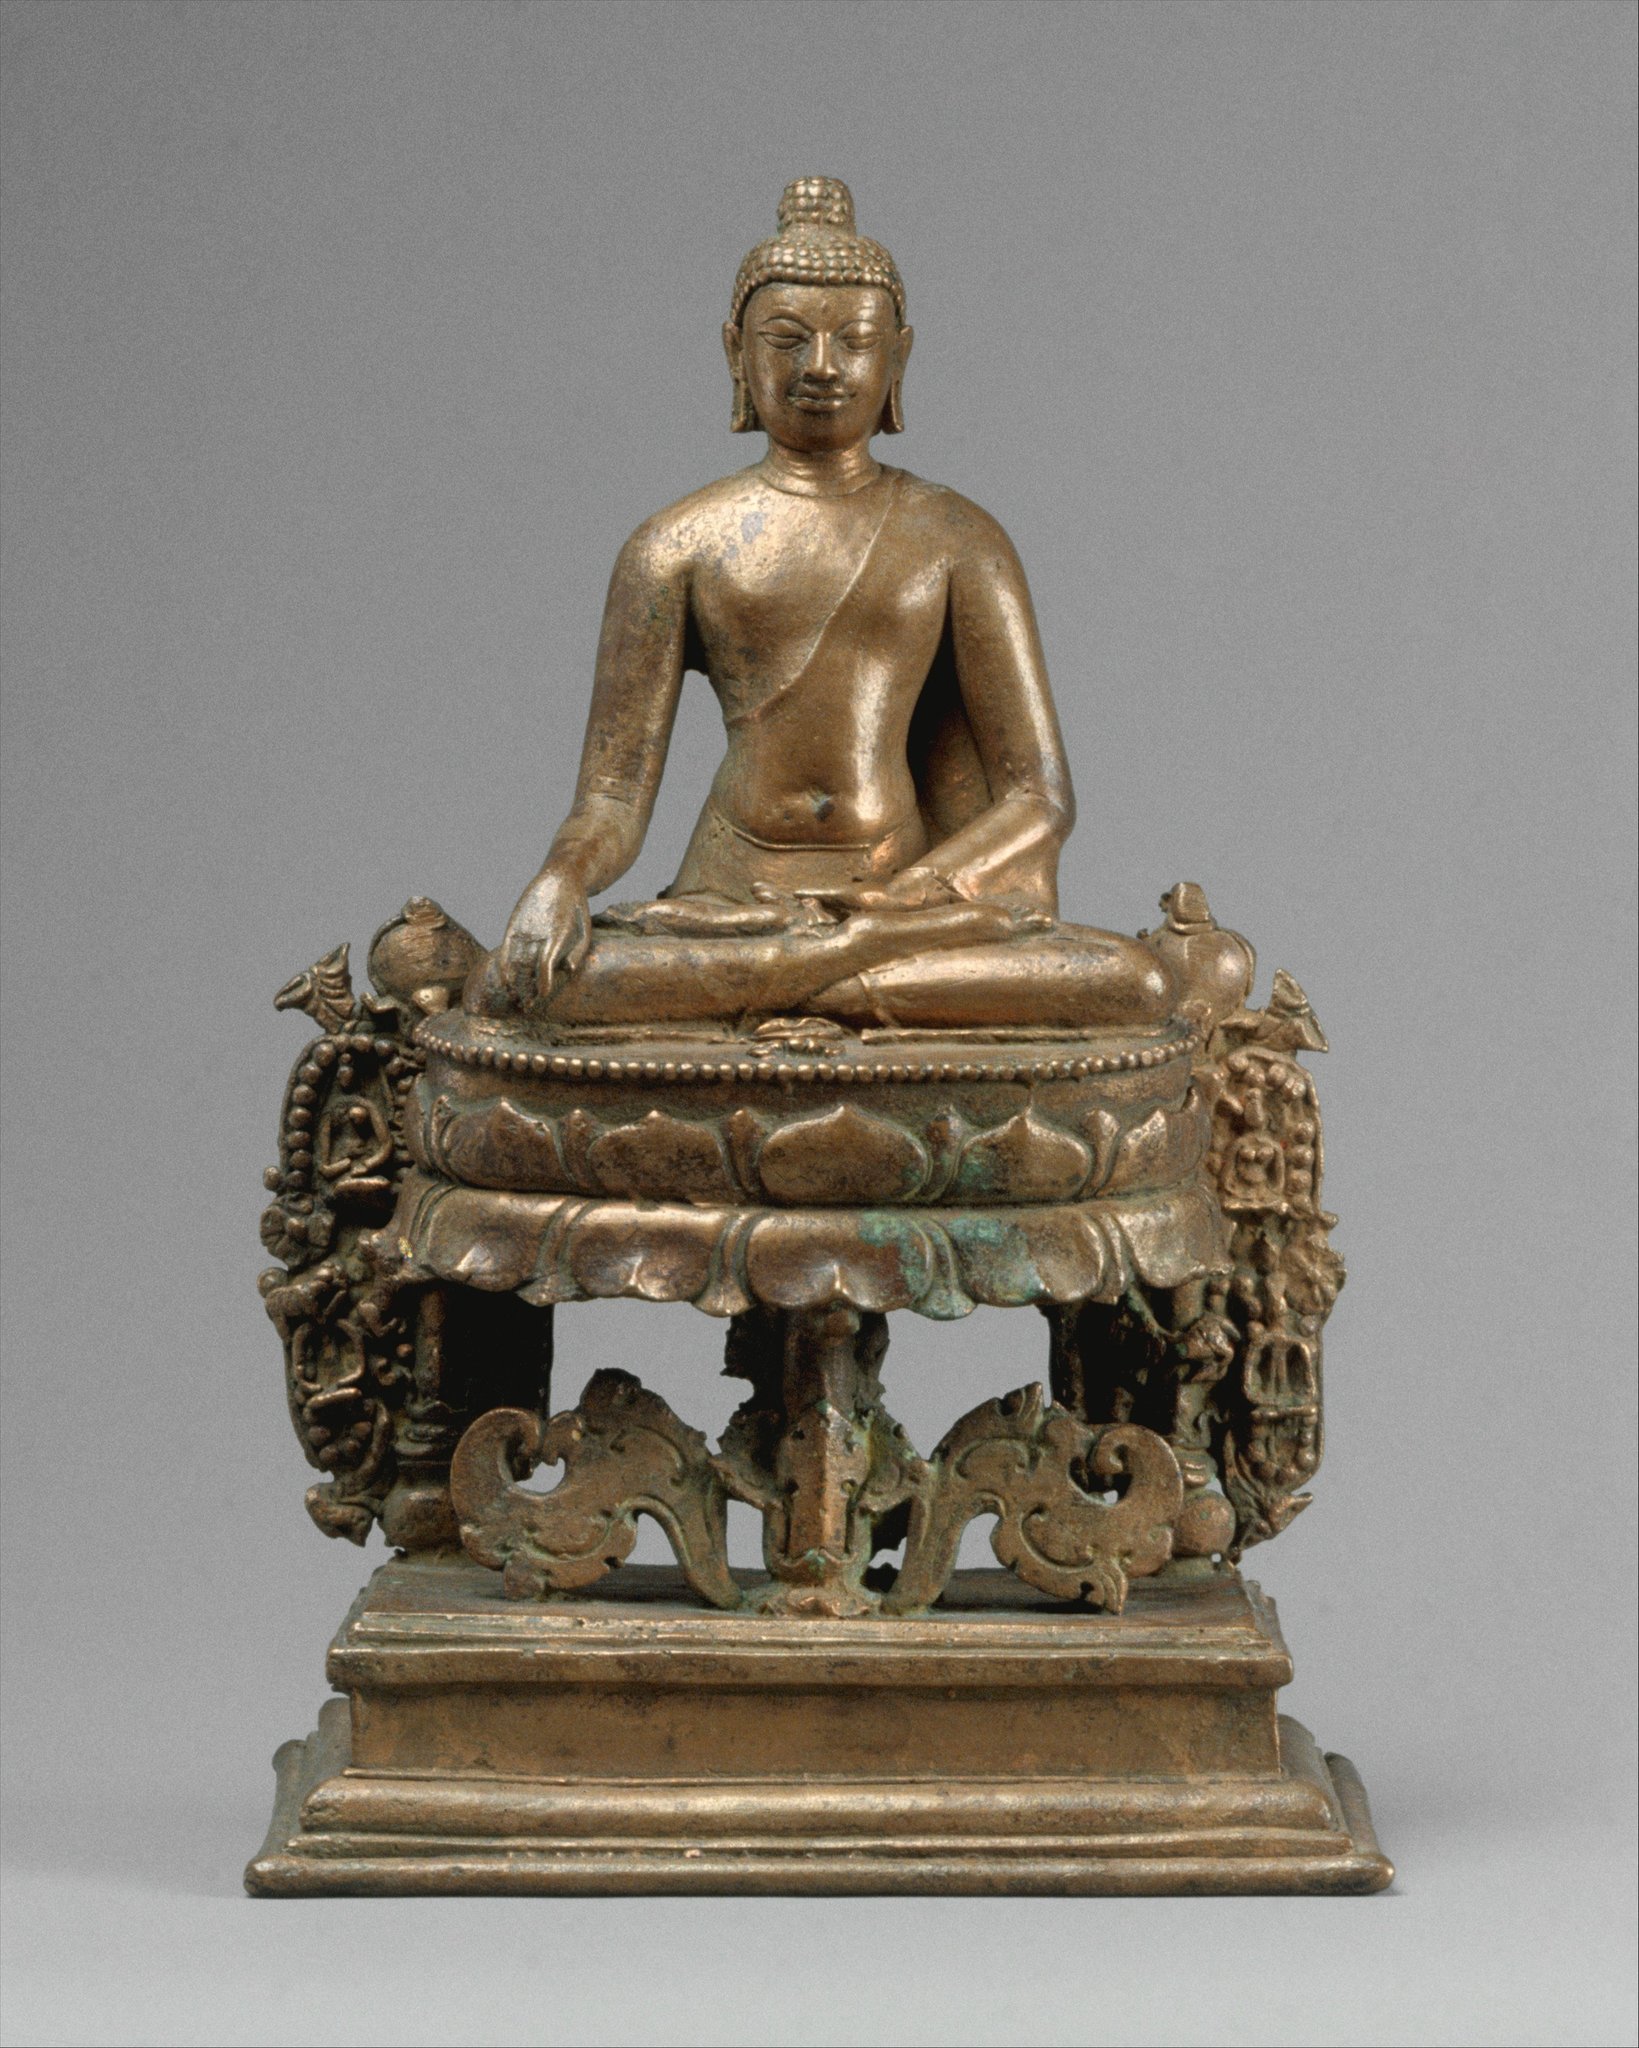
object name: figure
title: Lotus-Enthroned Buddha Akshobhya, the Transcendent Buddha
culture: bangladeshi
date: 701-833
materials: bronze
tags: buddhism,akshobhya,buddha